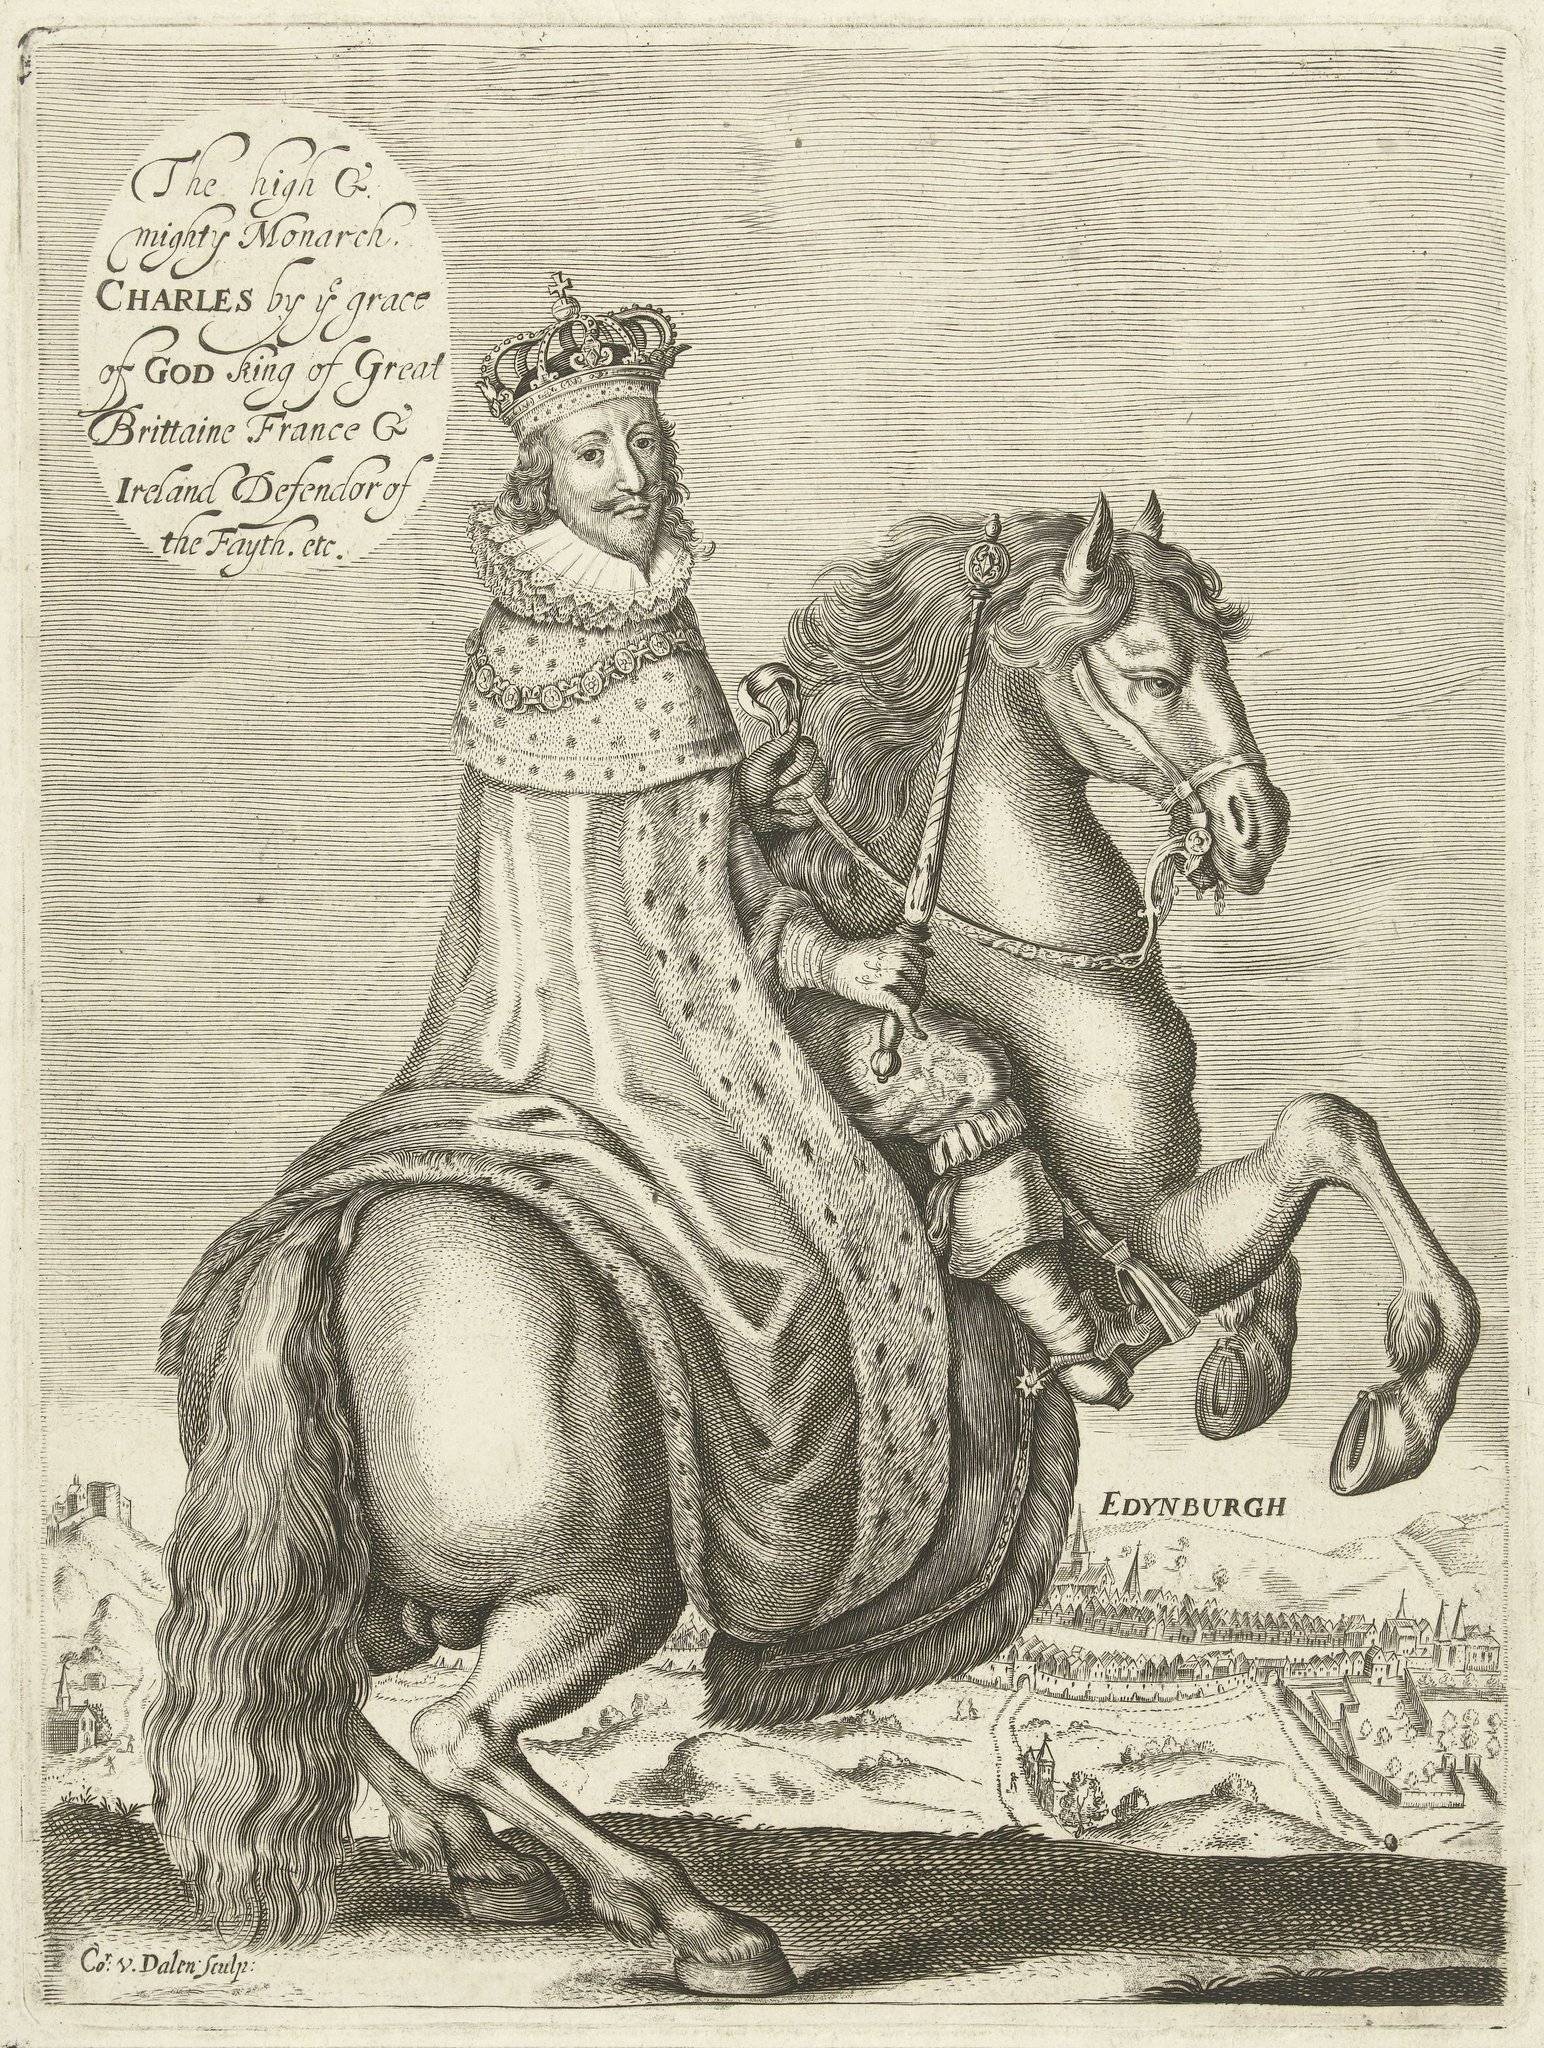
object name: print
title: The high and mighty Monarch Charles by y grace of God king of Great Brittaine France & Ireland Defendor of the Fayth. etc.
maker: cornelis van dalen (i)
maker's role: print maker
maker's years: 1602-1665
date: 1625-1665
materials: paper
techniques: engraving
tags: london, karel i (koning van engeland), equestrian statue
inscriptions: collector's mark: Lugt 2228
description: Ruiterportret van Karel I, Koning van Engeland, gekleed in koningsmantel, met kroon op zijn hoofd en scepter in zijn hand. In het landschap op de achtergrond ligt de plaats Edinburgh.